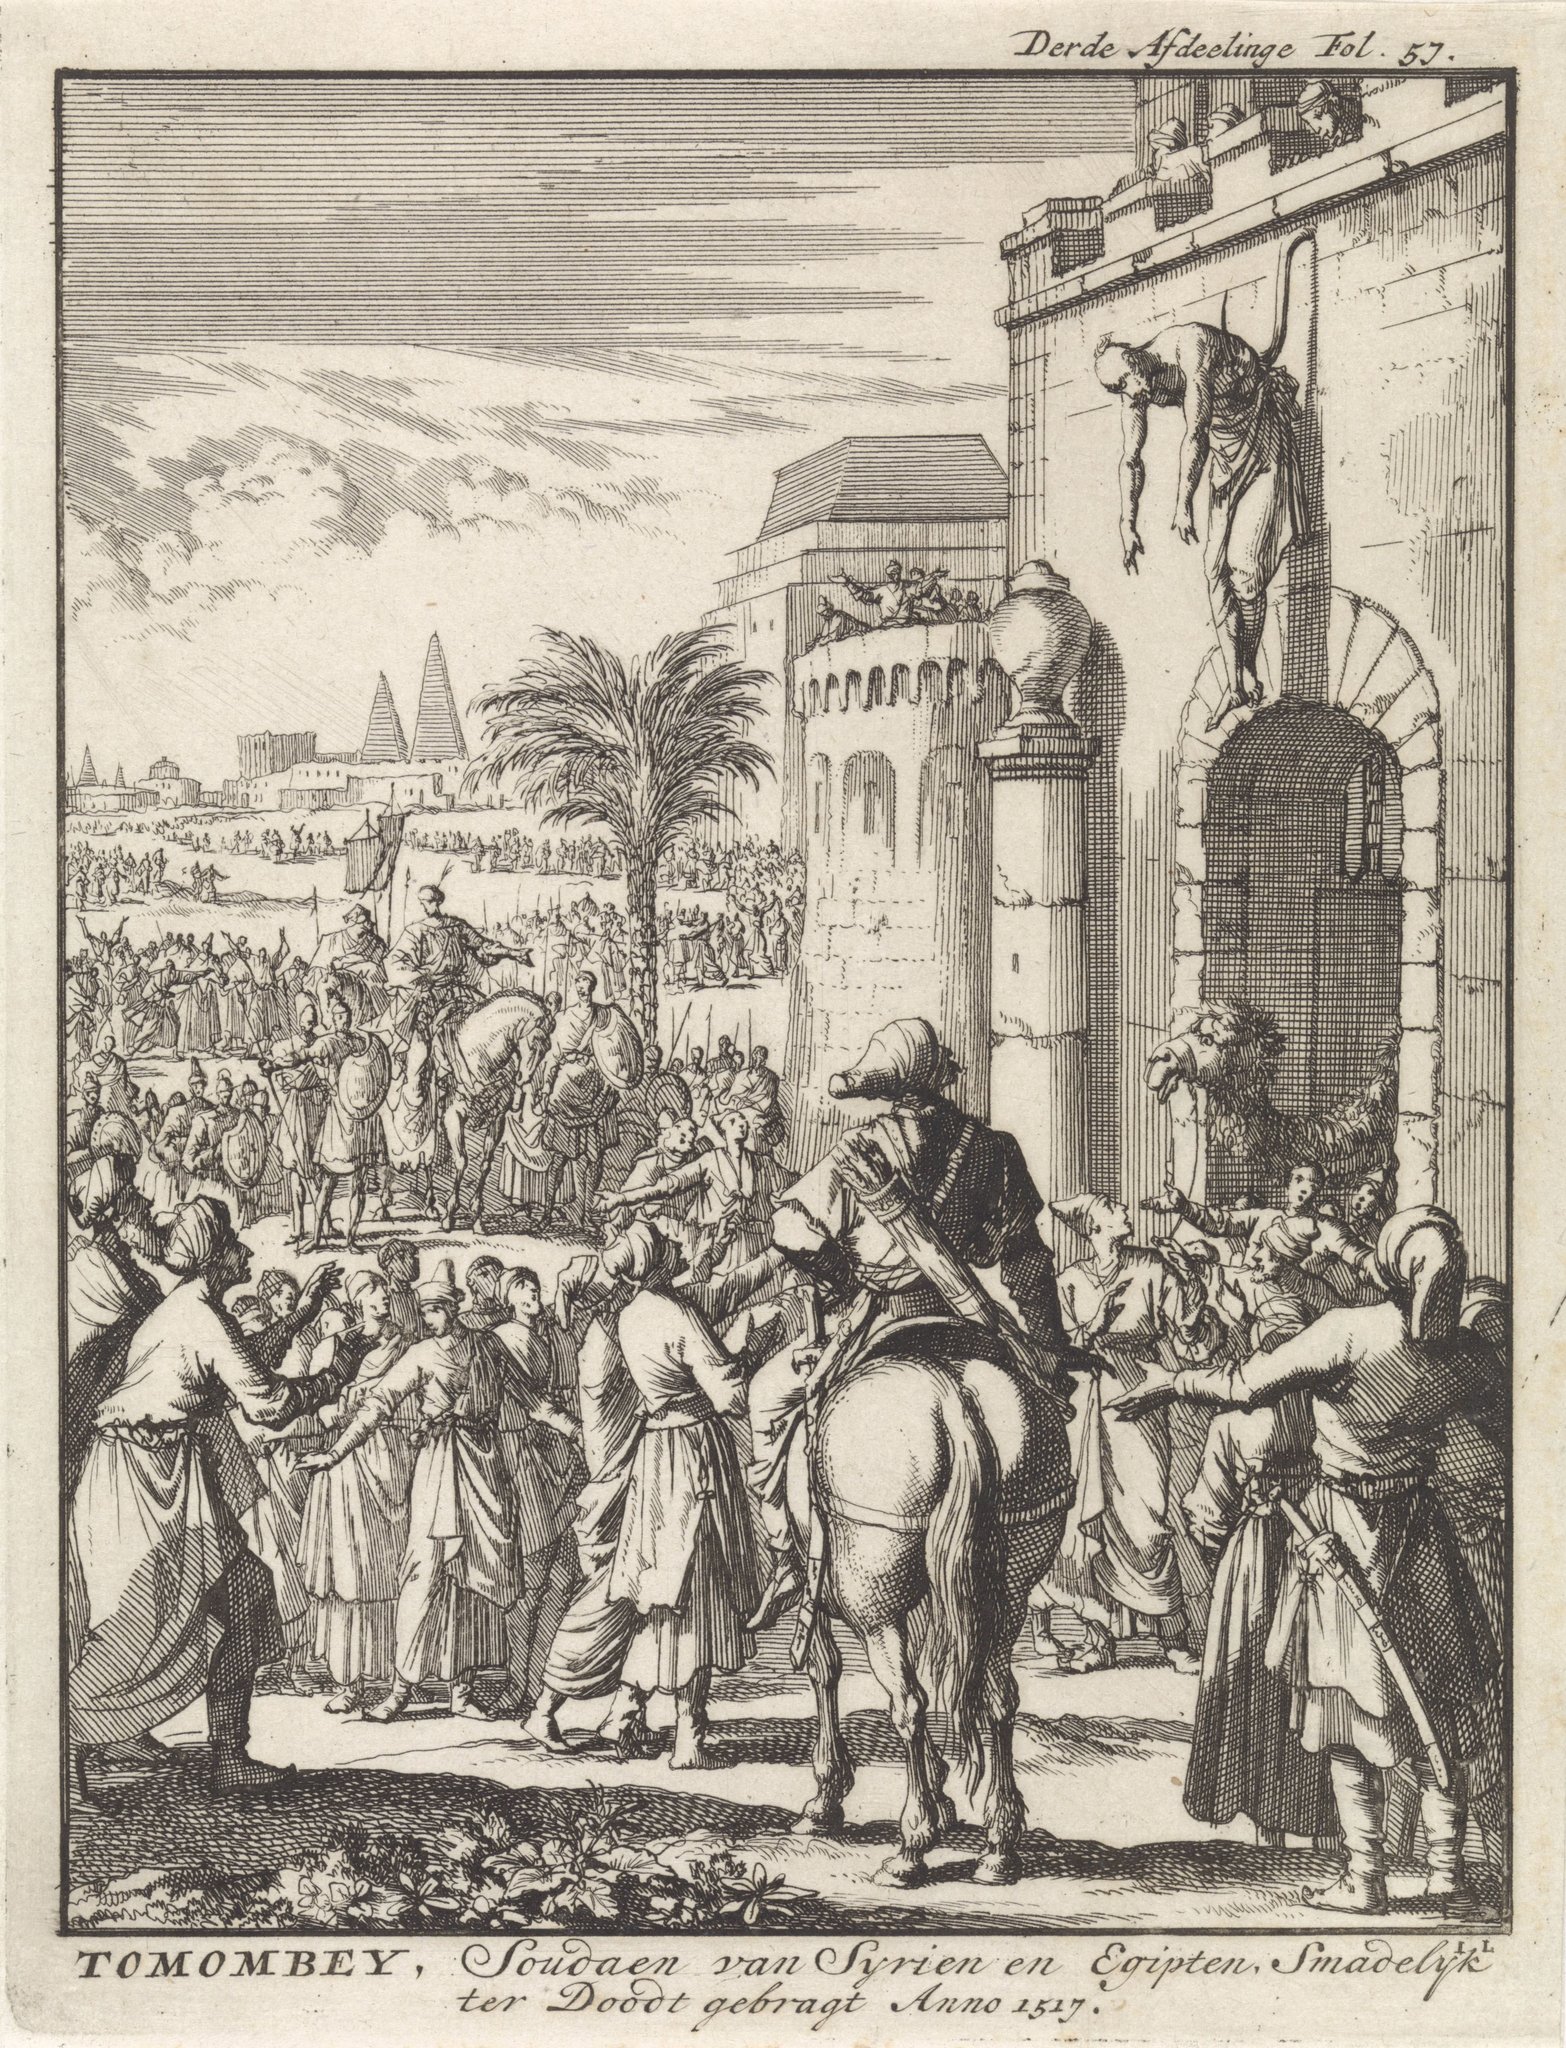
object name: book illustration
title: Tomombey, Soudaen van Syrien en Egipten, Smadelyk ter Doodt gebragt Anno 1517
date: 1698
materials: paper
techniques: etching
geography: amsterdam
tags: violent death by hanging, city-gate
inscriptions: collector's mark: Lugt 2228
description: Illustratie uit: Bos, Lambert van den. Treur-toonneel der doorluchtige mannen, of Op- en ondergang der grooten, 3 delen. Amsterdam: Jan Claesz ten Hoorn, 1698, dl. II.